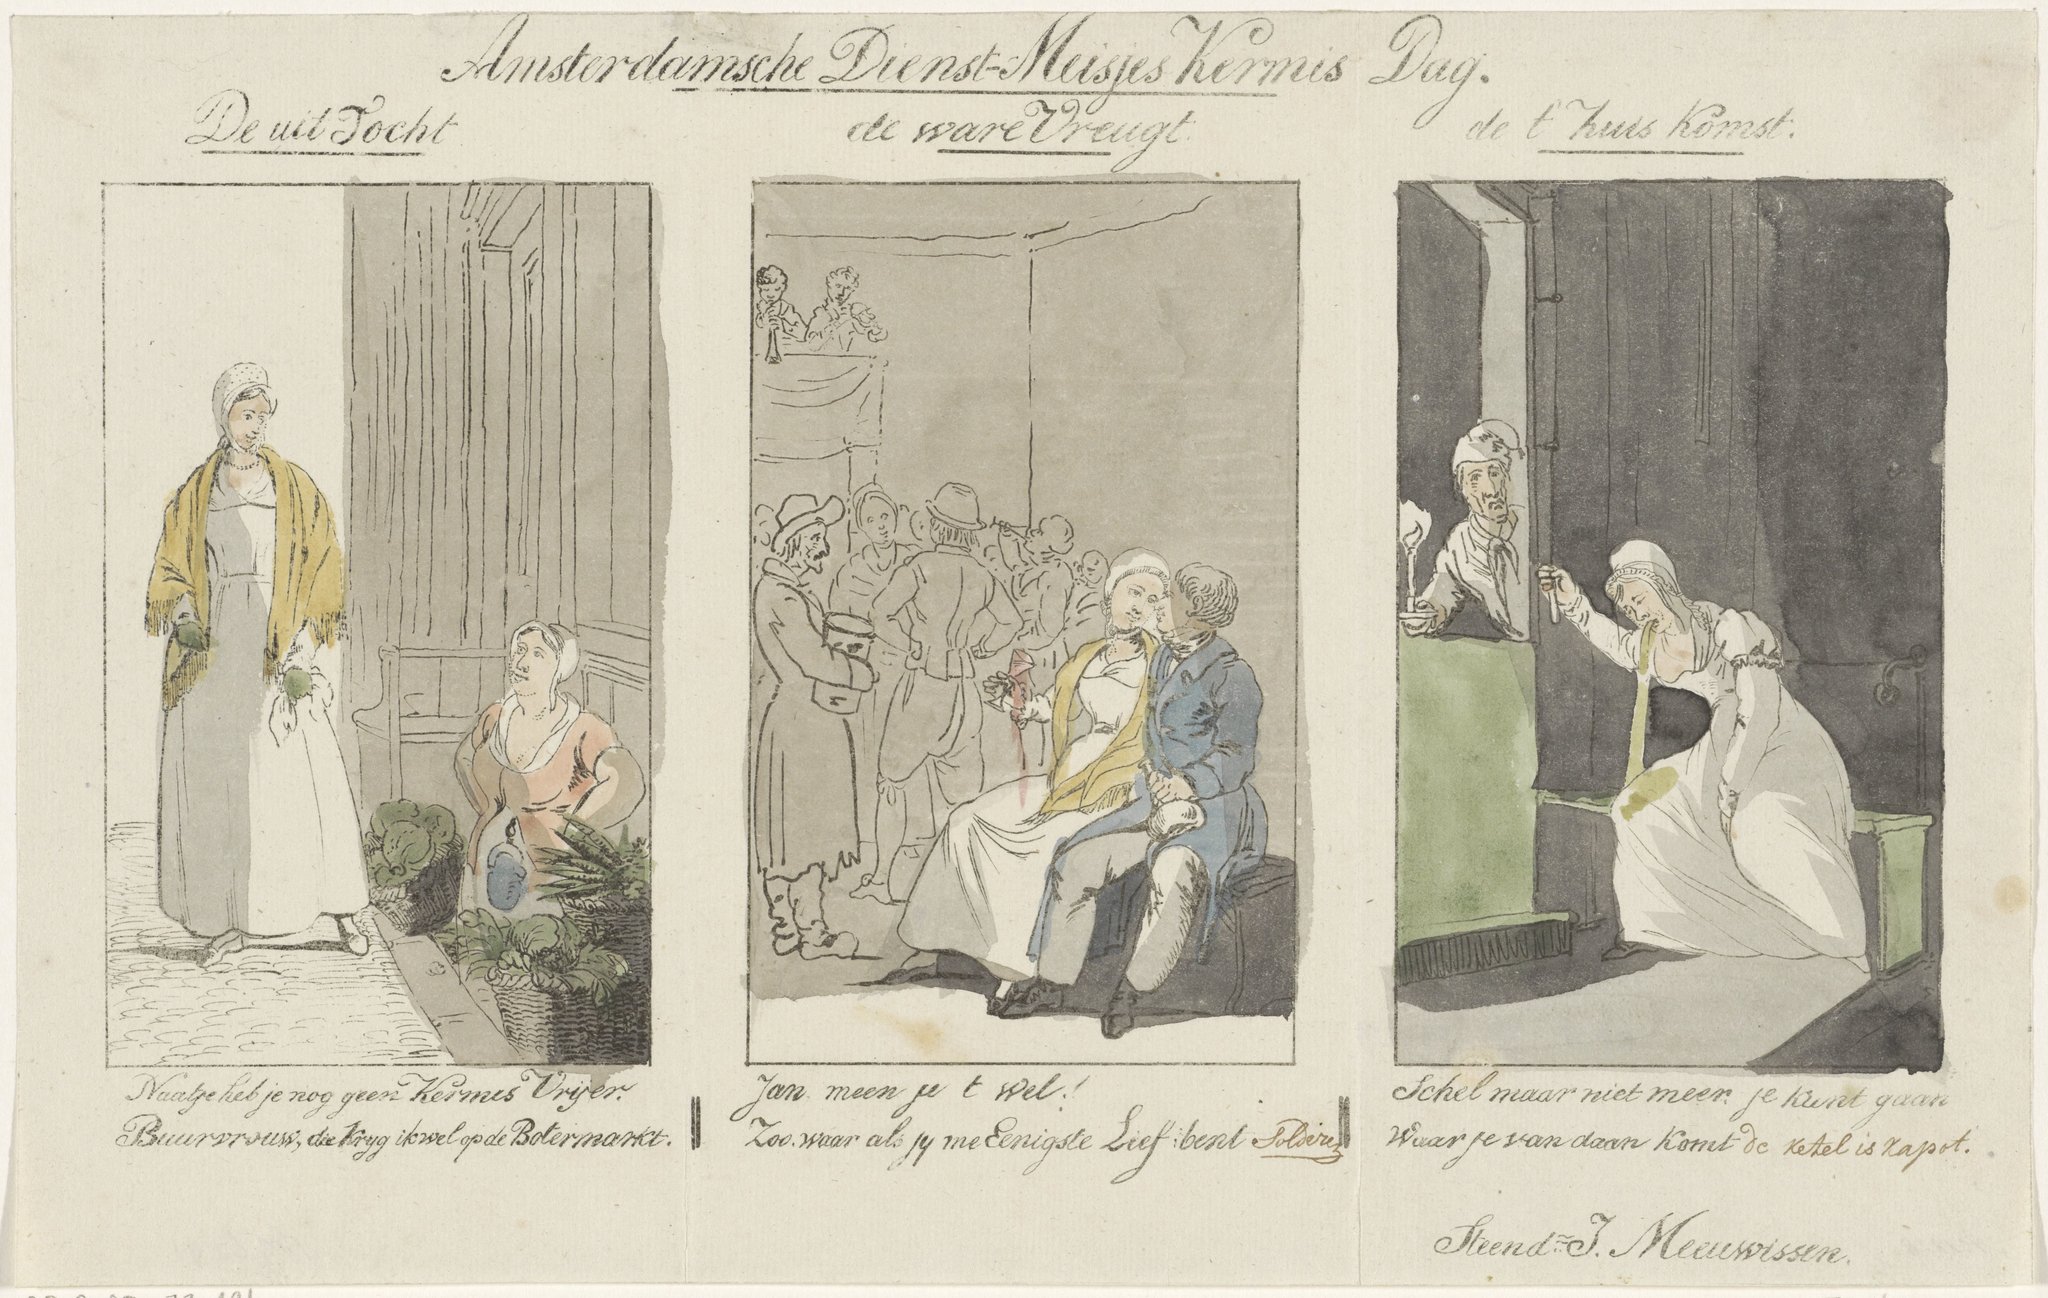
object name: print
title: Spotprent op de Amsterdamse dienstmeisjes die zich misdragen op de kermis, 1828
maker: j. meeuwissen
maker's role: lithograaf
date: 1828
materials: paper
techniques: hand coloring, lithograph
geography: netherlands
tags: vomiting - aa - female human figure, drunkenness, pleasure fair and circus, maid ~ house personnel, amsterdam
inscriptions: inscription: ‘Ao. 1828.’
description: Spotprent op de Amsterdamse dienstmeisjes die zich misdragen op de kermis, september 1828. Drie opeenvolgende voorstellingen. 1 'De uittocht': de buurvrouw vraagt aan de meid of ze naar de kermis gaat. 2 'de ware vreugt': de dienstmeid die zich met haar vrijer aan het bedrinken is. 3 'de t'huis komst': de dronken meid belt bij haar huis aan, maar wordt weggestuurd. Iedere afbeelding met een regel bovenschrift en twee regels onderschift.